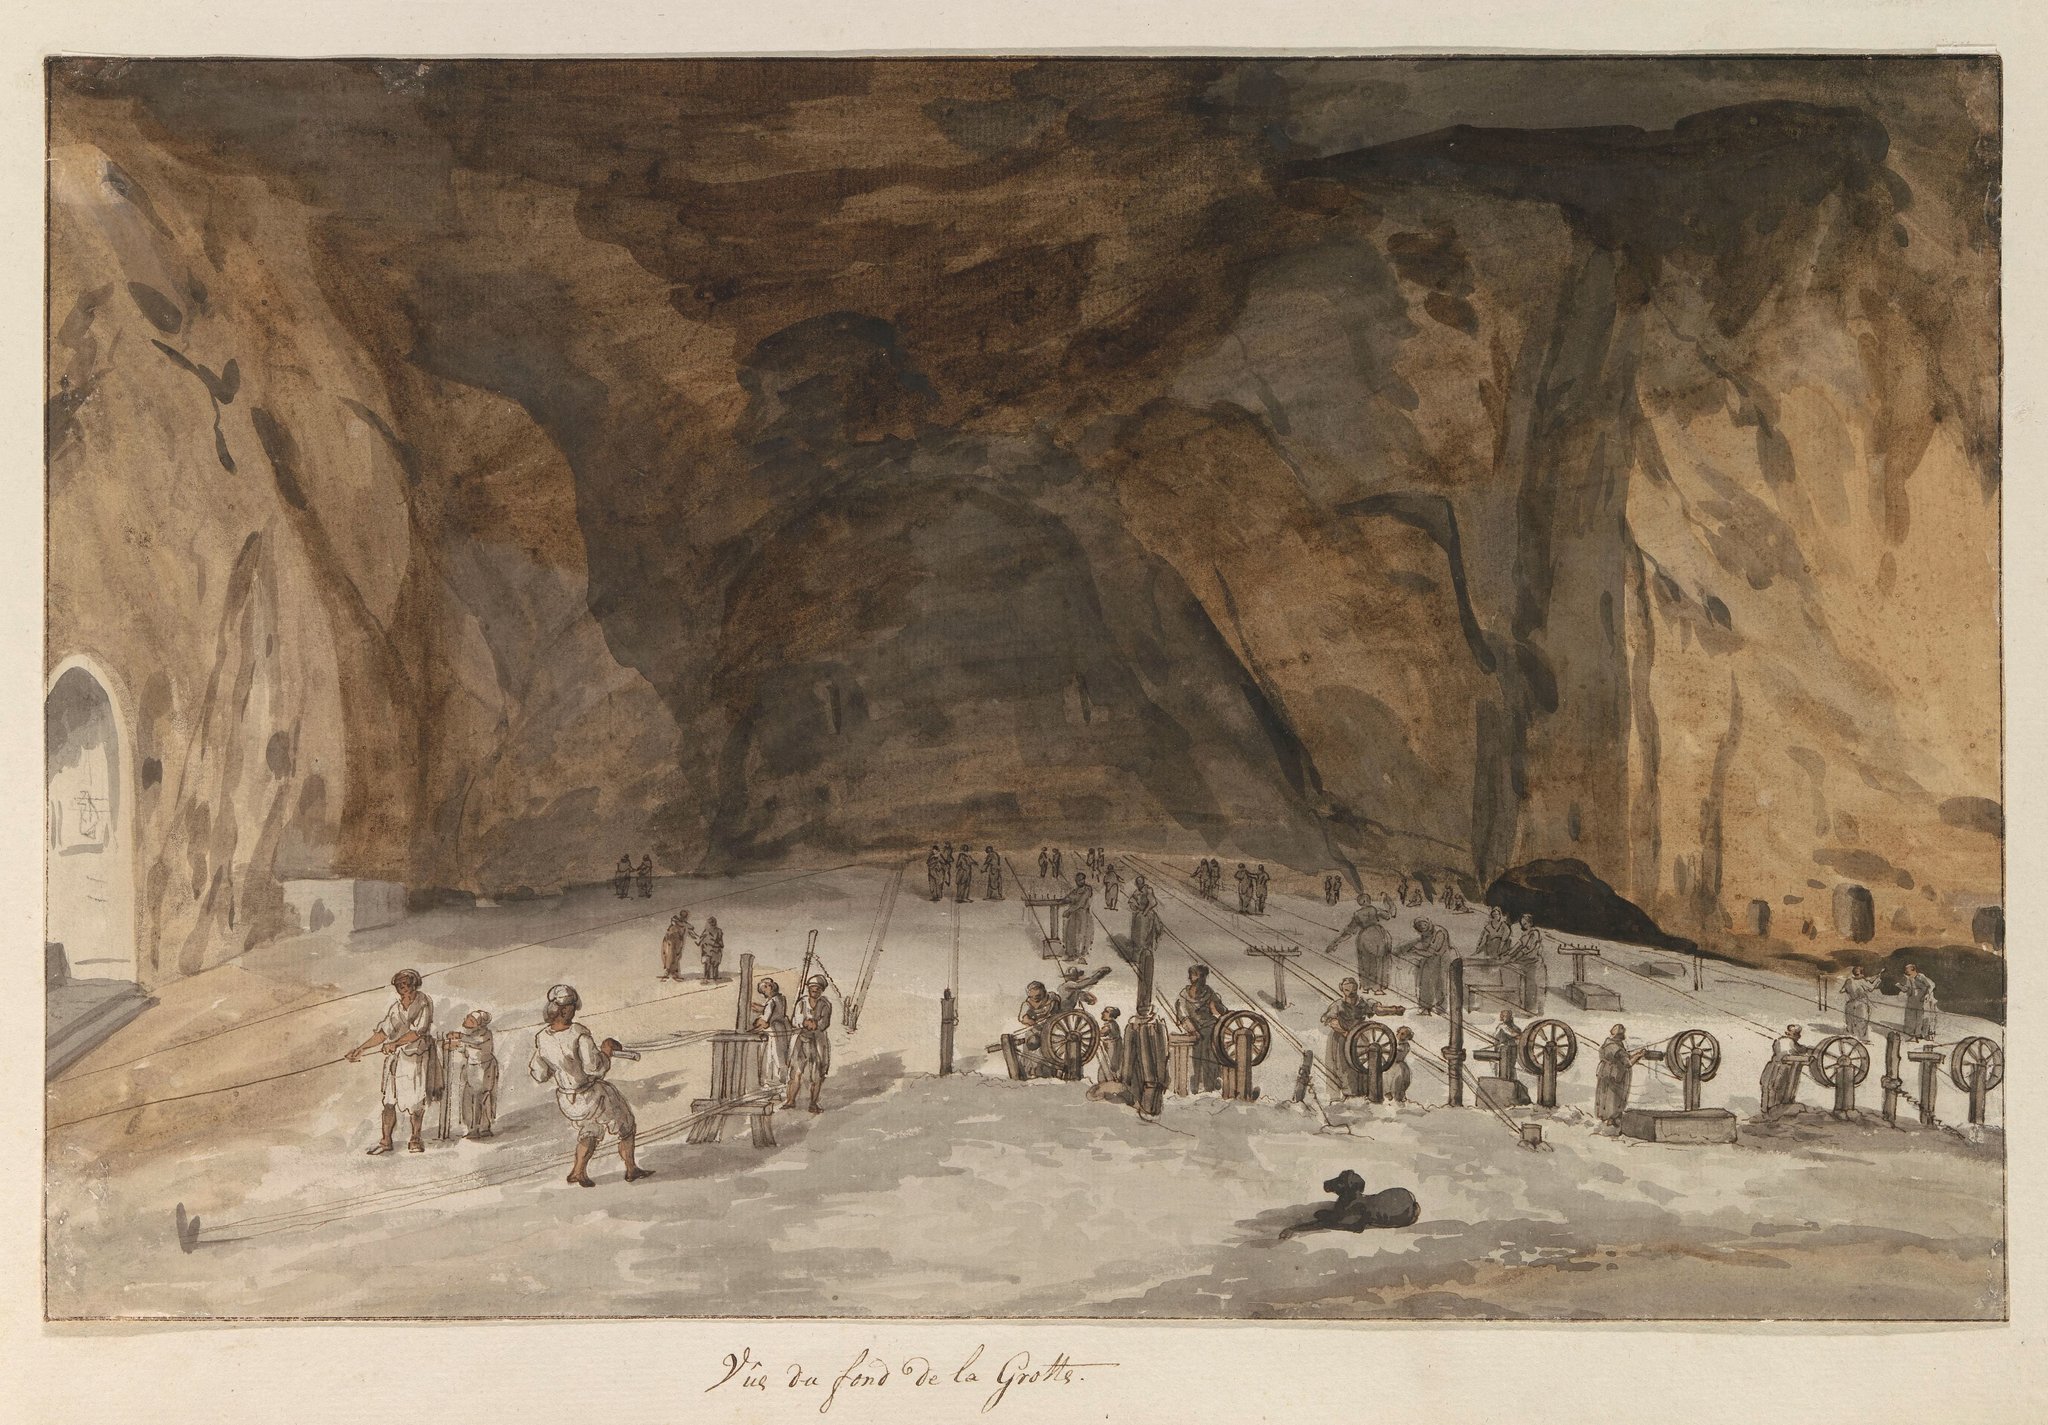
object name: drawing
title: Interieur van grot Santa Maria Capella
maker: louis ducros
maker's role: draughtsman, print maker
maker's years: 1748-1810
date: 1778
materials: chalk, paper, watercolor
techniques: brush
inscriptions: number: ‘No 28 Vue du fond de la Grotte’